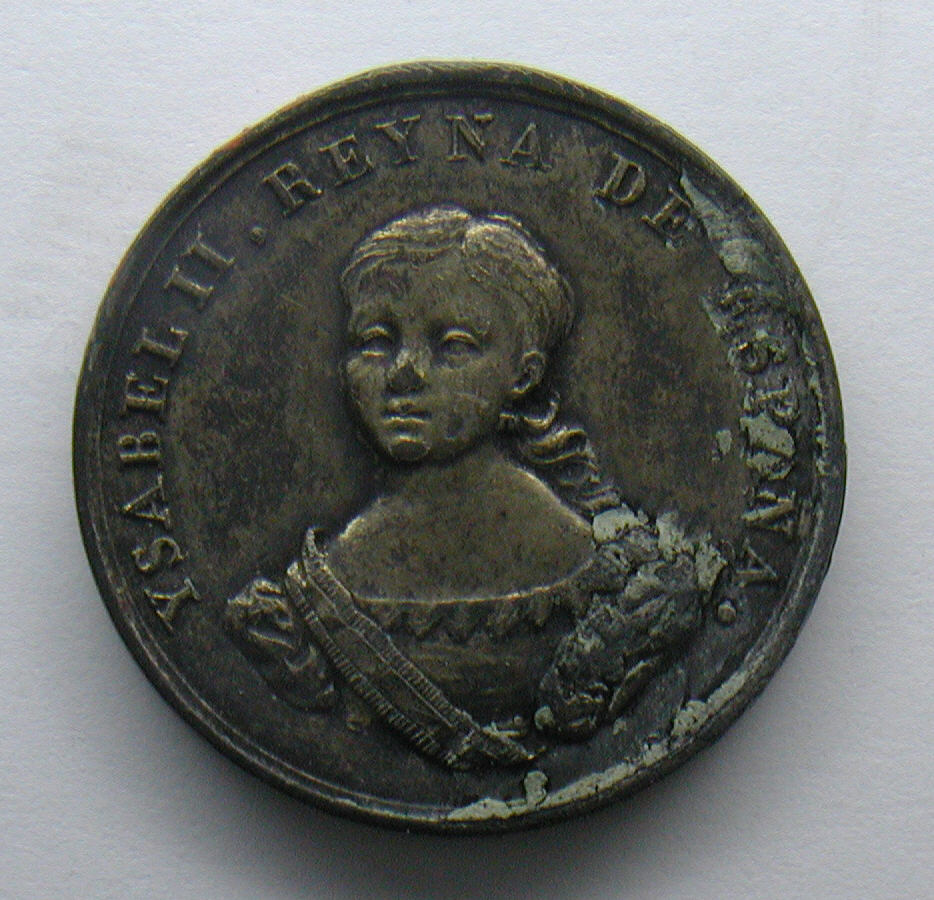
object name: coin or token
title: Token or coin (?)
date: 1834-1866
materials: silver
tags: girls,portraits,coins